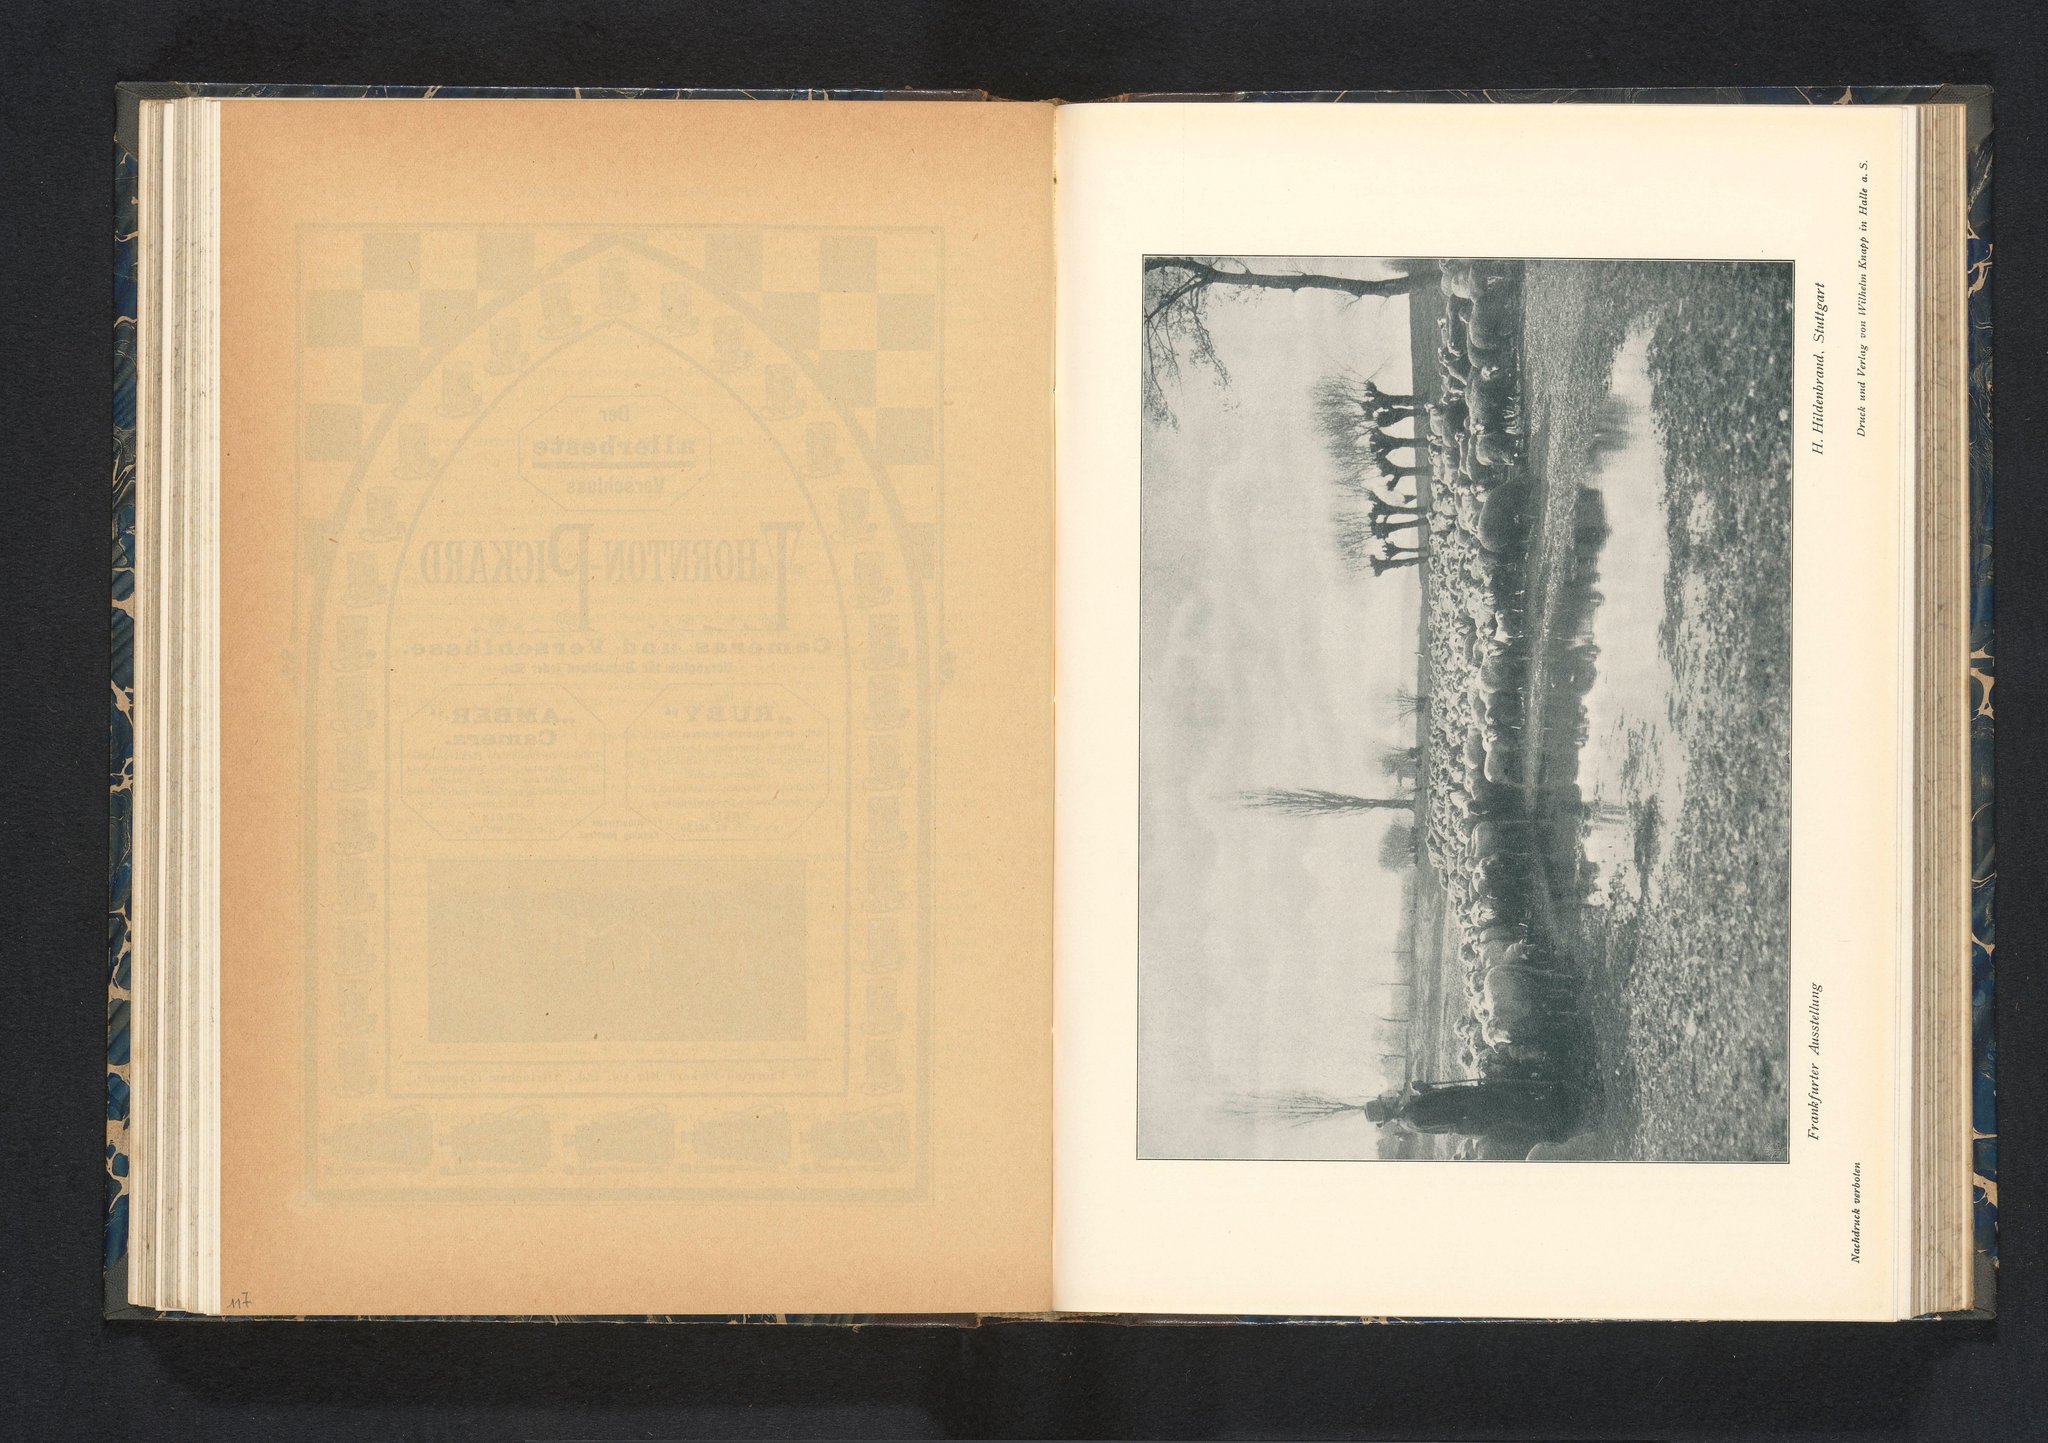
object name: photomechanical print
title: Frankfurter Ausstellung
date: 1896-1901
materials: paper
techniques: autotype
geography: halle an der saale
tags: herding, herdsman, herdswoman, shepherd, shepherdess, cowherd, etc., sheep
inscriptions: monogram: ‘LEIPZIG/ S G’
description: Prent op tweede ongenummerde pagina na pagina 148.